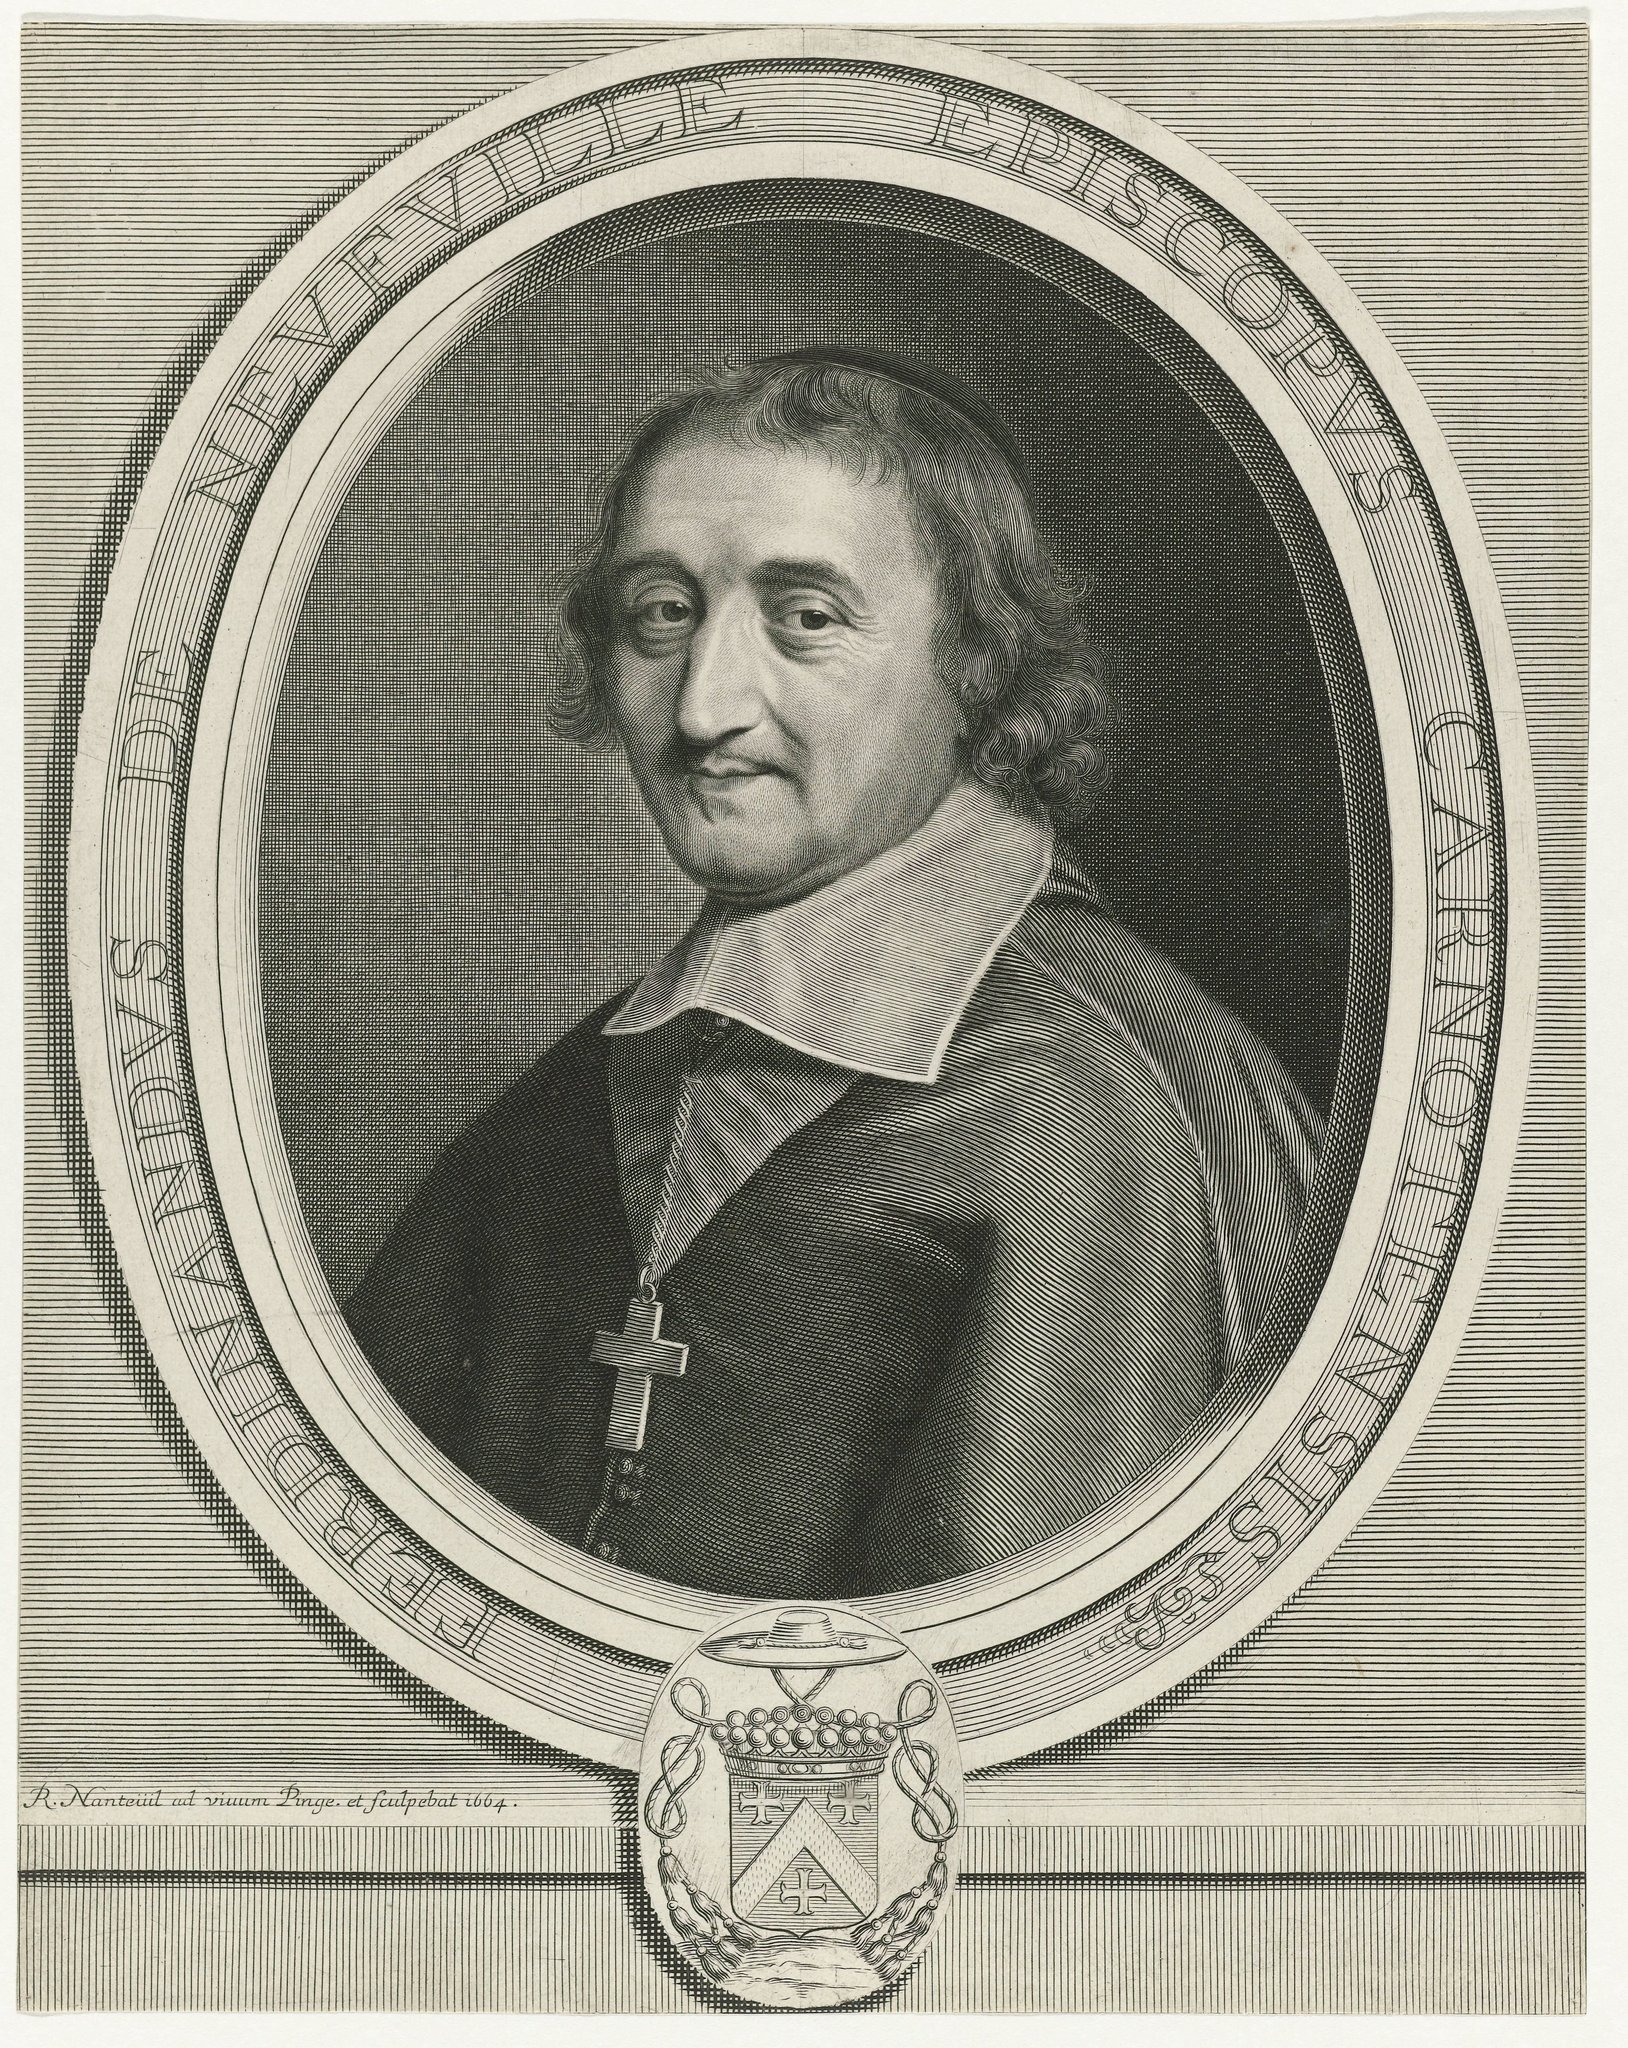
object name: print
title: Portret Ferdinand de Neufville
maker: robert nanteuil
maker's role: print maker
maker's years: 1623-1678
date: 1664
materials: paper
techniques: engraving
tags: paris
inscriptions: date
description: Buste naar links, in ovale lijst met randschrift. Wapen middenonder.